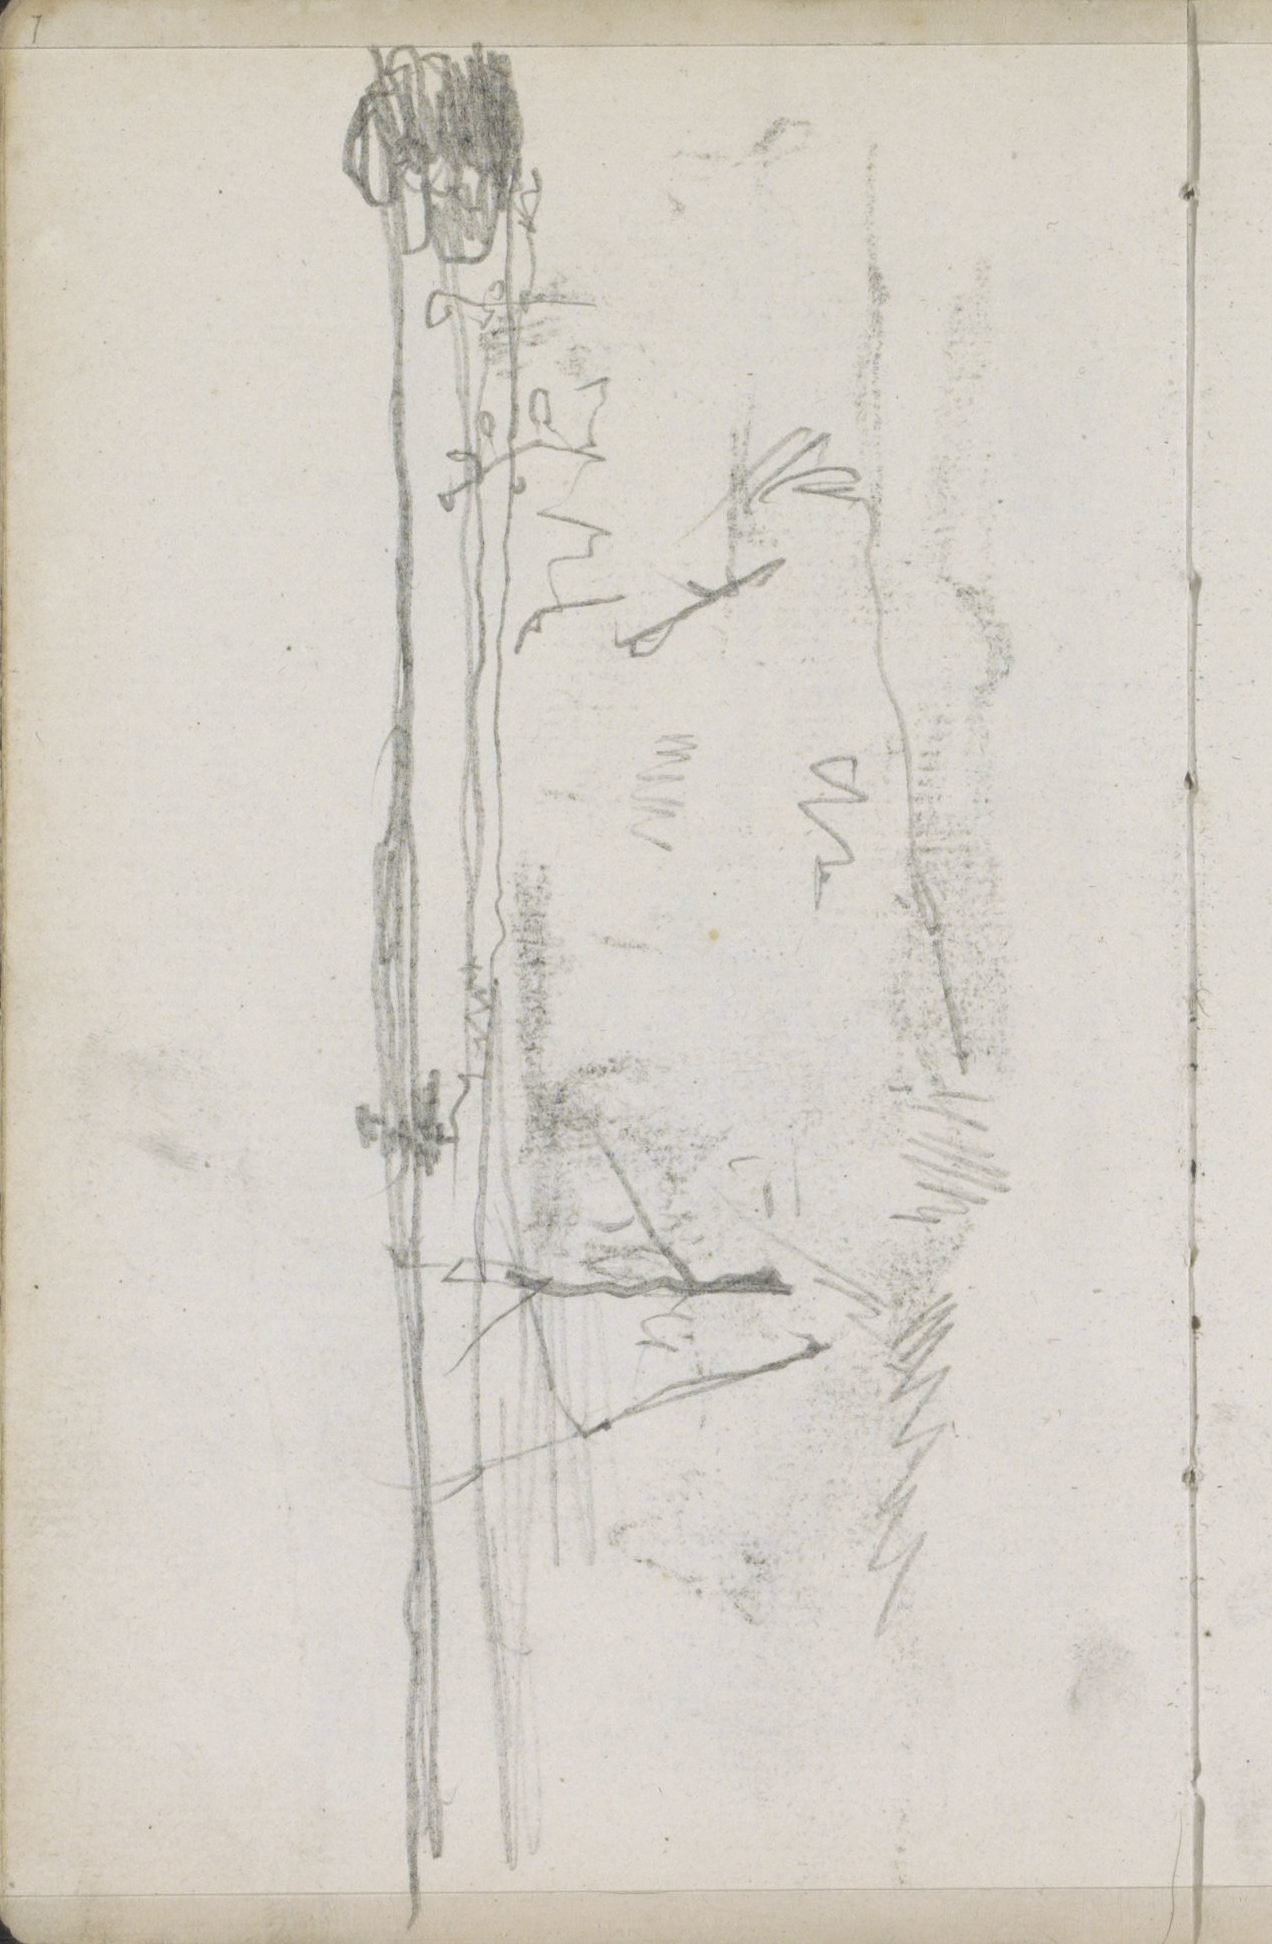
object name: sketchbook leaf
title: Landschap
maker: george hendrik breitner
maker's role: draughtsman, painter, print maker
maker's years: 1857-1923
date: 1884-1886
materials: paper, pencil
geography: drenthe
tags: landscapes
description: Pagina 7 uit een schetsboek met 67 bladen vervaardigd in Drenthe.